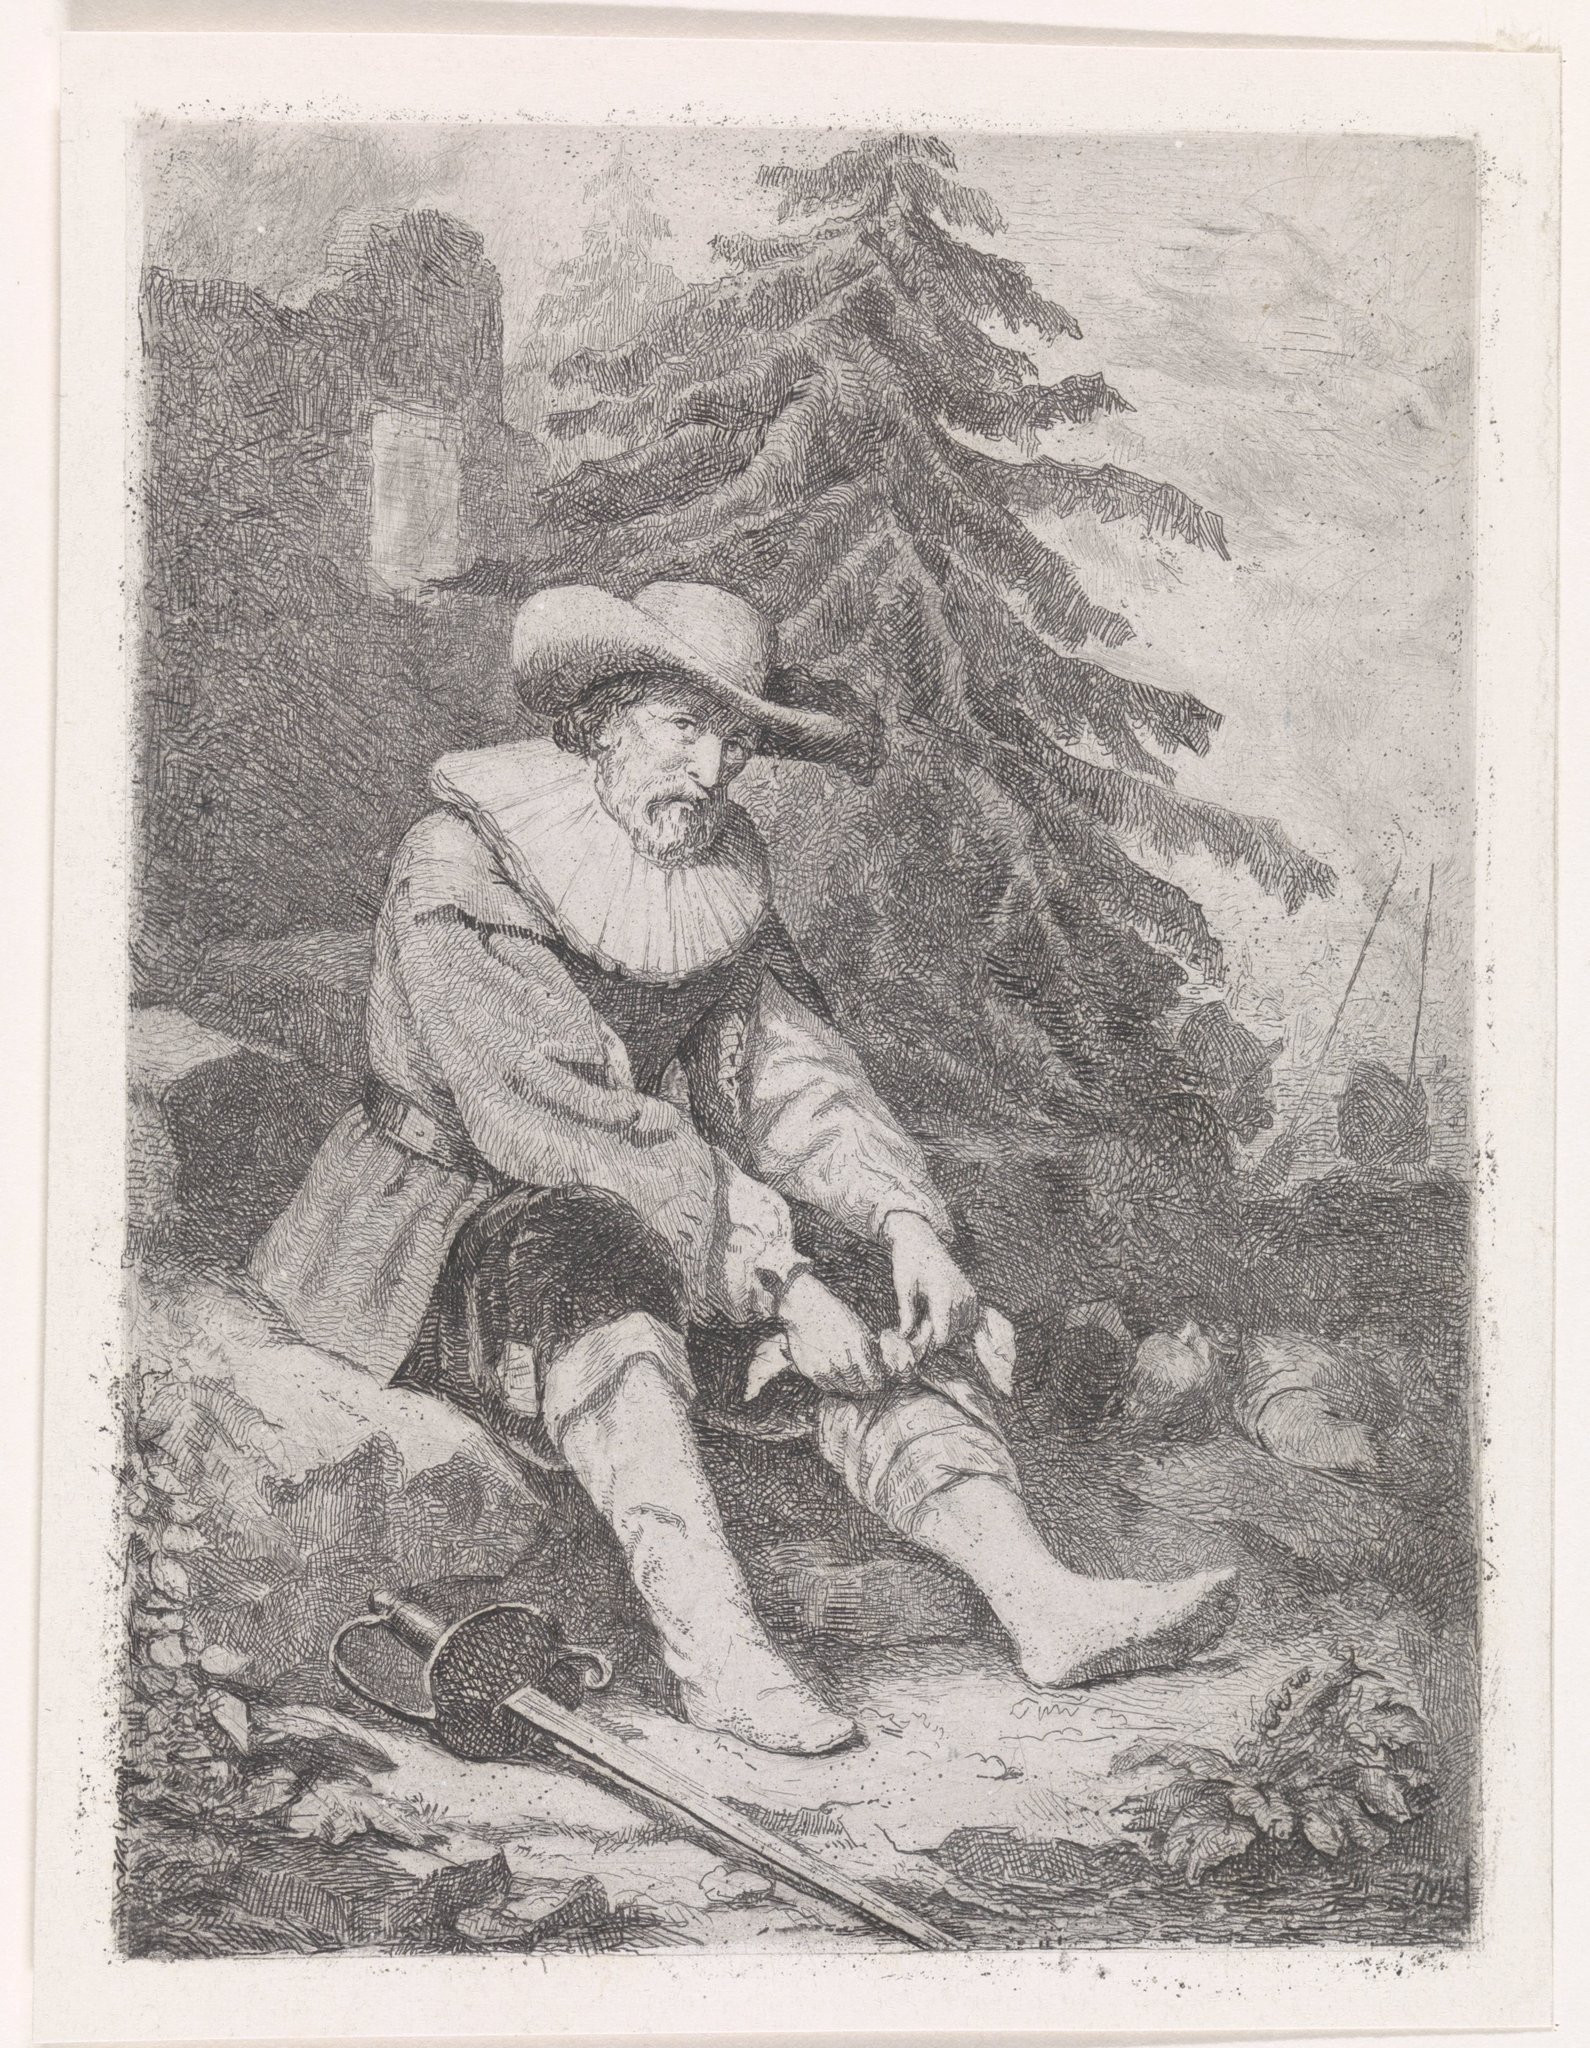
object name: print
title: Gewonde krijgsman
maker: david van der kellen (1827-1895)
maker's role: draughtsman, print maker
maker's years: 1827-1895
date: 1837-1886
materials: paper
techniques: drypoint, etching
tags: landscapes, hacking and thrusting weapons, infections and wounds, the soldier; the soldier's life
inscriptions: collector's mark: Lugt 2228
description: In een landschap verbindt een krijgsman zijn gewonde linkerbeen. Rechts naast hem ligt het levenloze lichaam van een soldaat, en links zijn rapier. Op de achtergrond zijn enkele naaldbomen en de contouren van een verwoeste gevel te zien.